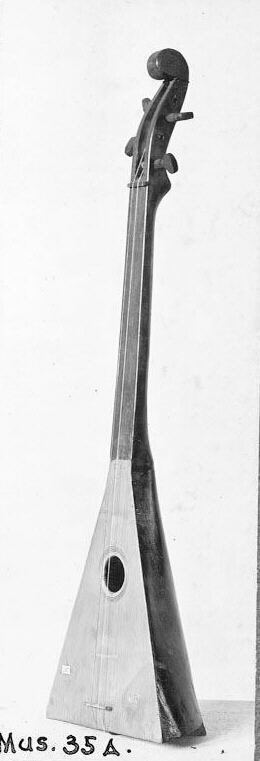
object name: balalaika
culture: russian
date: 1801-1900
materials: wood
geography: russia